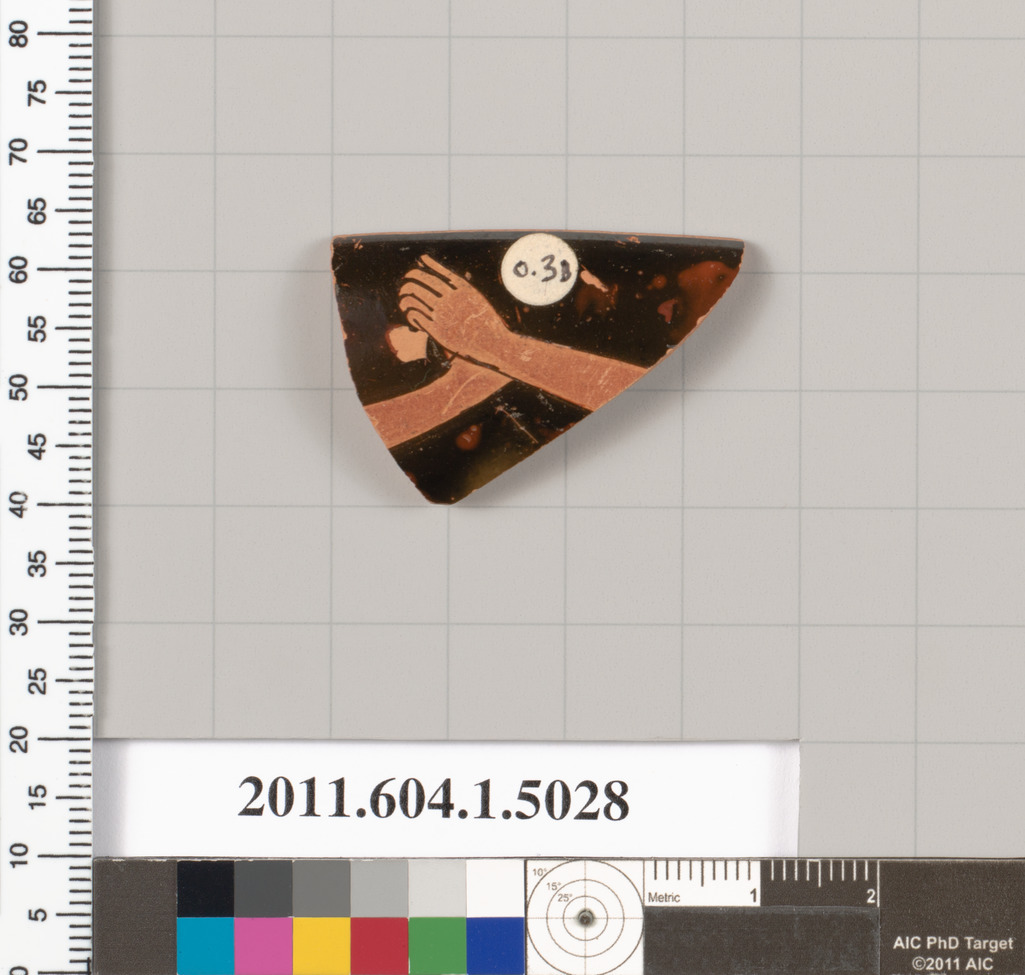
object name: kylix fragment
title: Terracotta fragment of a kylix (drinking cup)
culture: greek, attic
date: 500-480 BCE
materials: terracotta